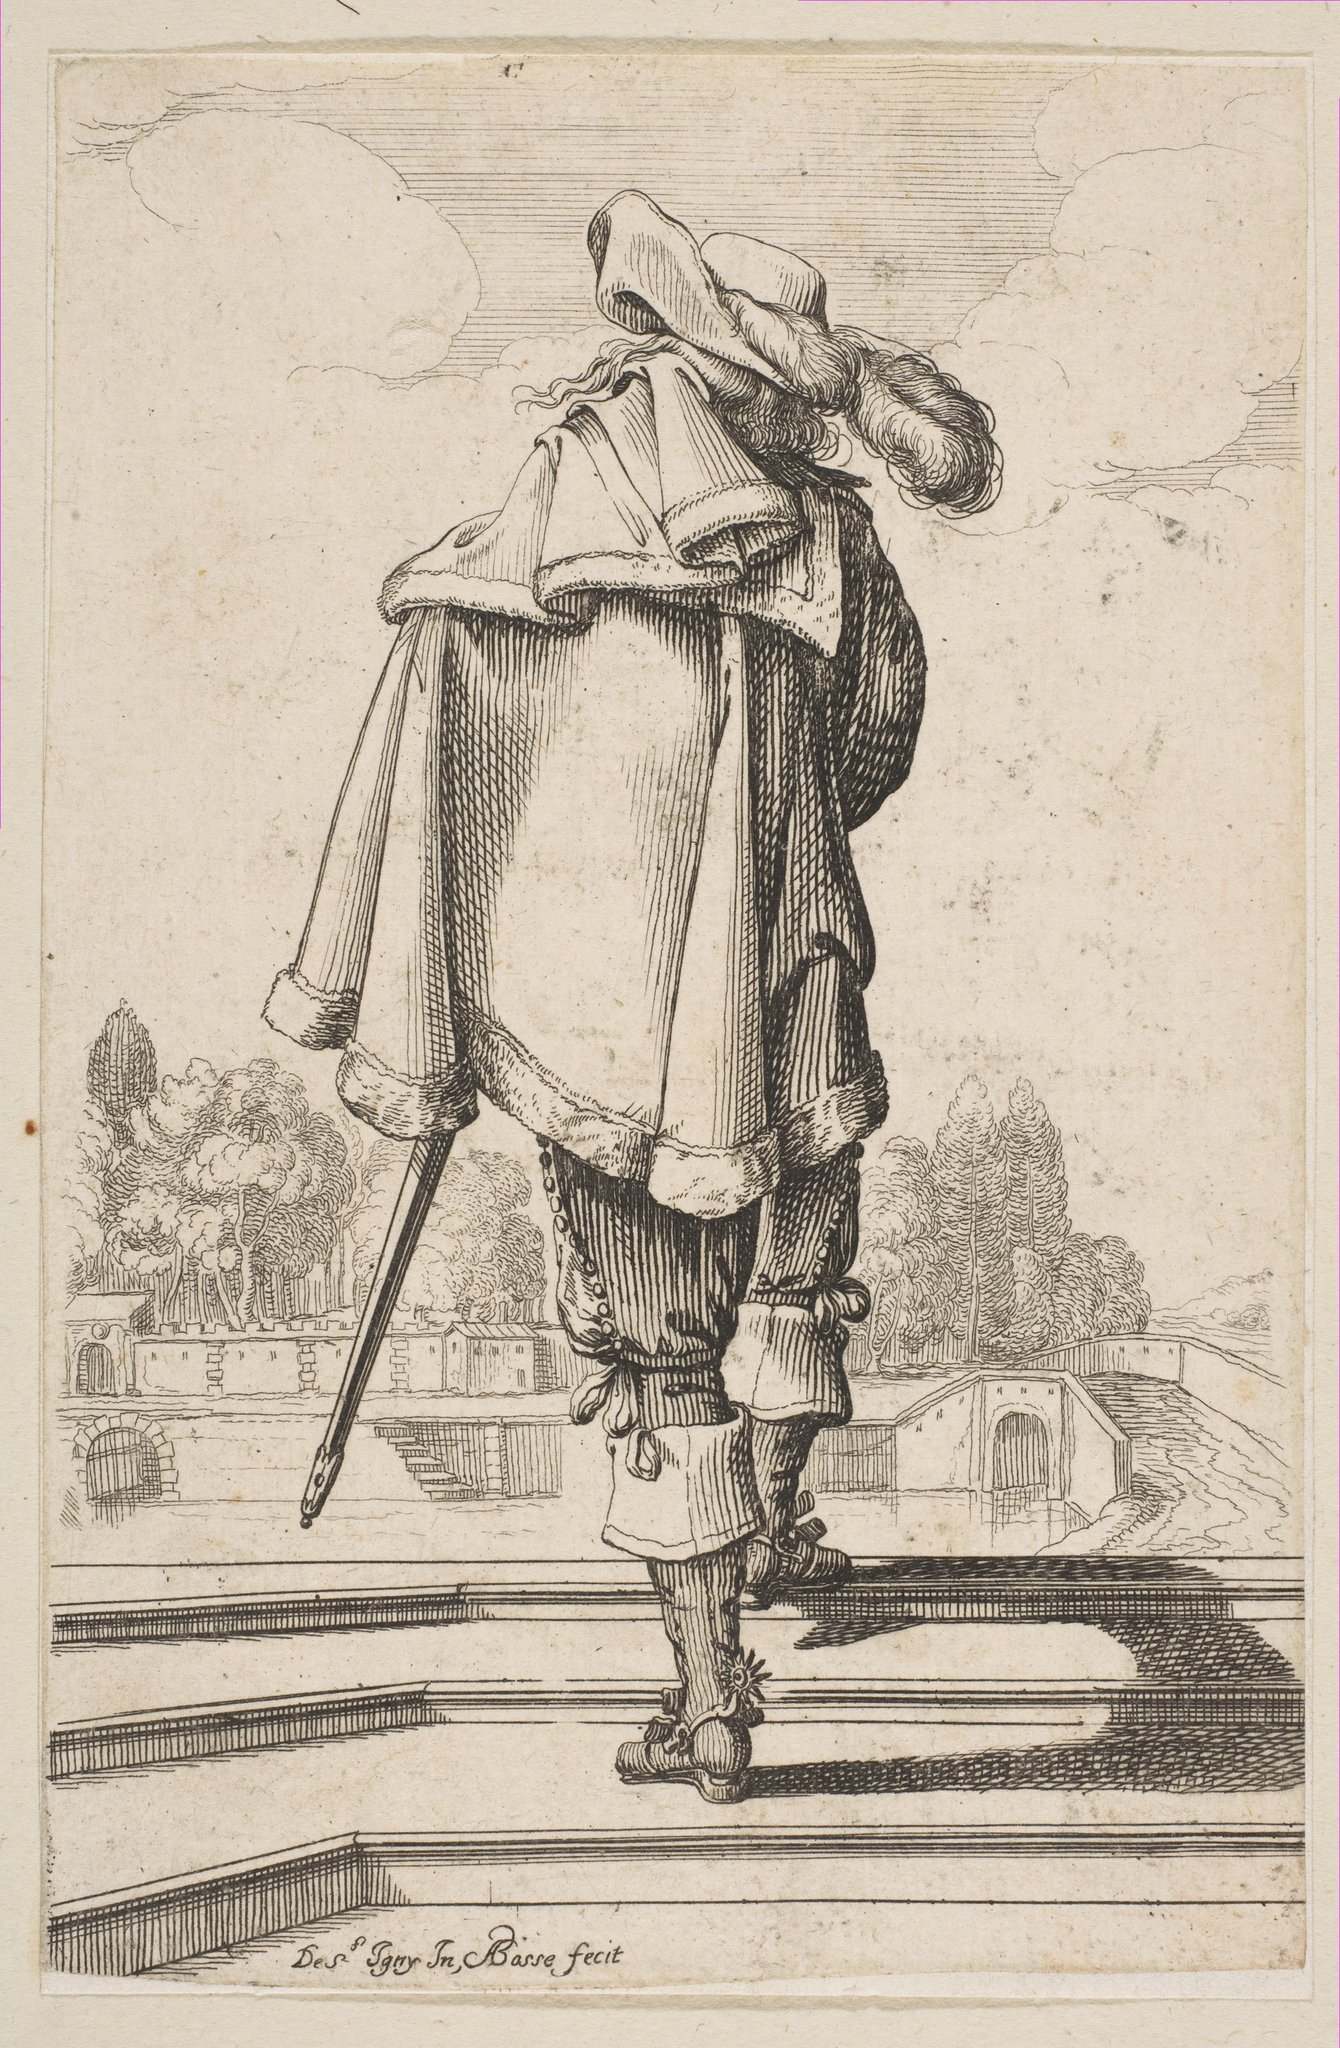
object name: print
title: Gentleman in a Cape and Plumed Hat Seen from the Back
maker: abraham bosse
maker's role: artist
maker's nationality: french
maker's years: 1602-1676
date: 1629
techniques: etching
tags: men